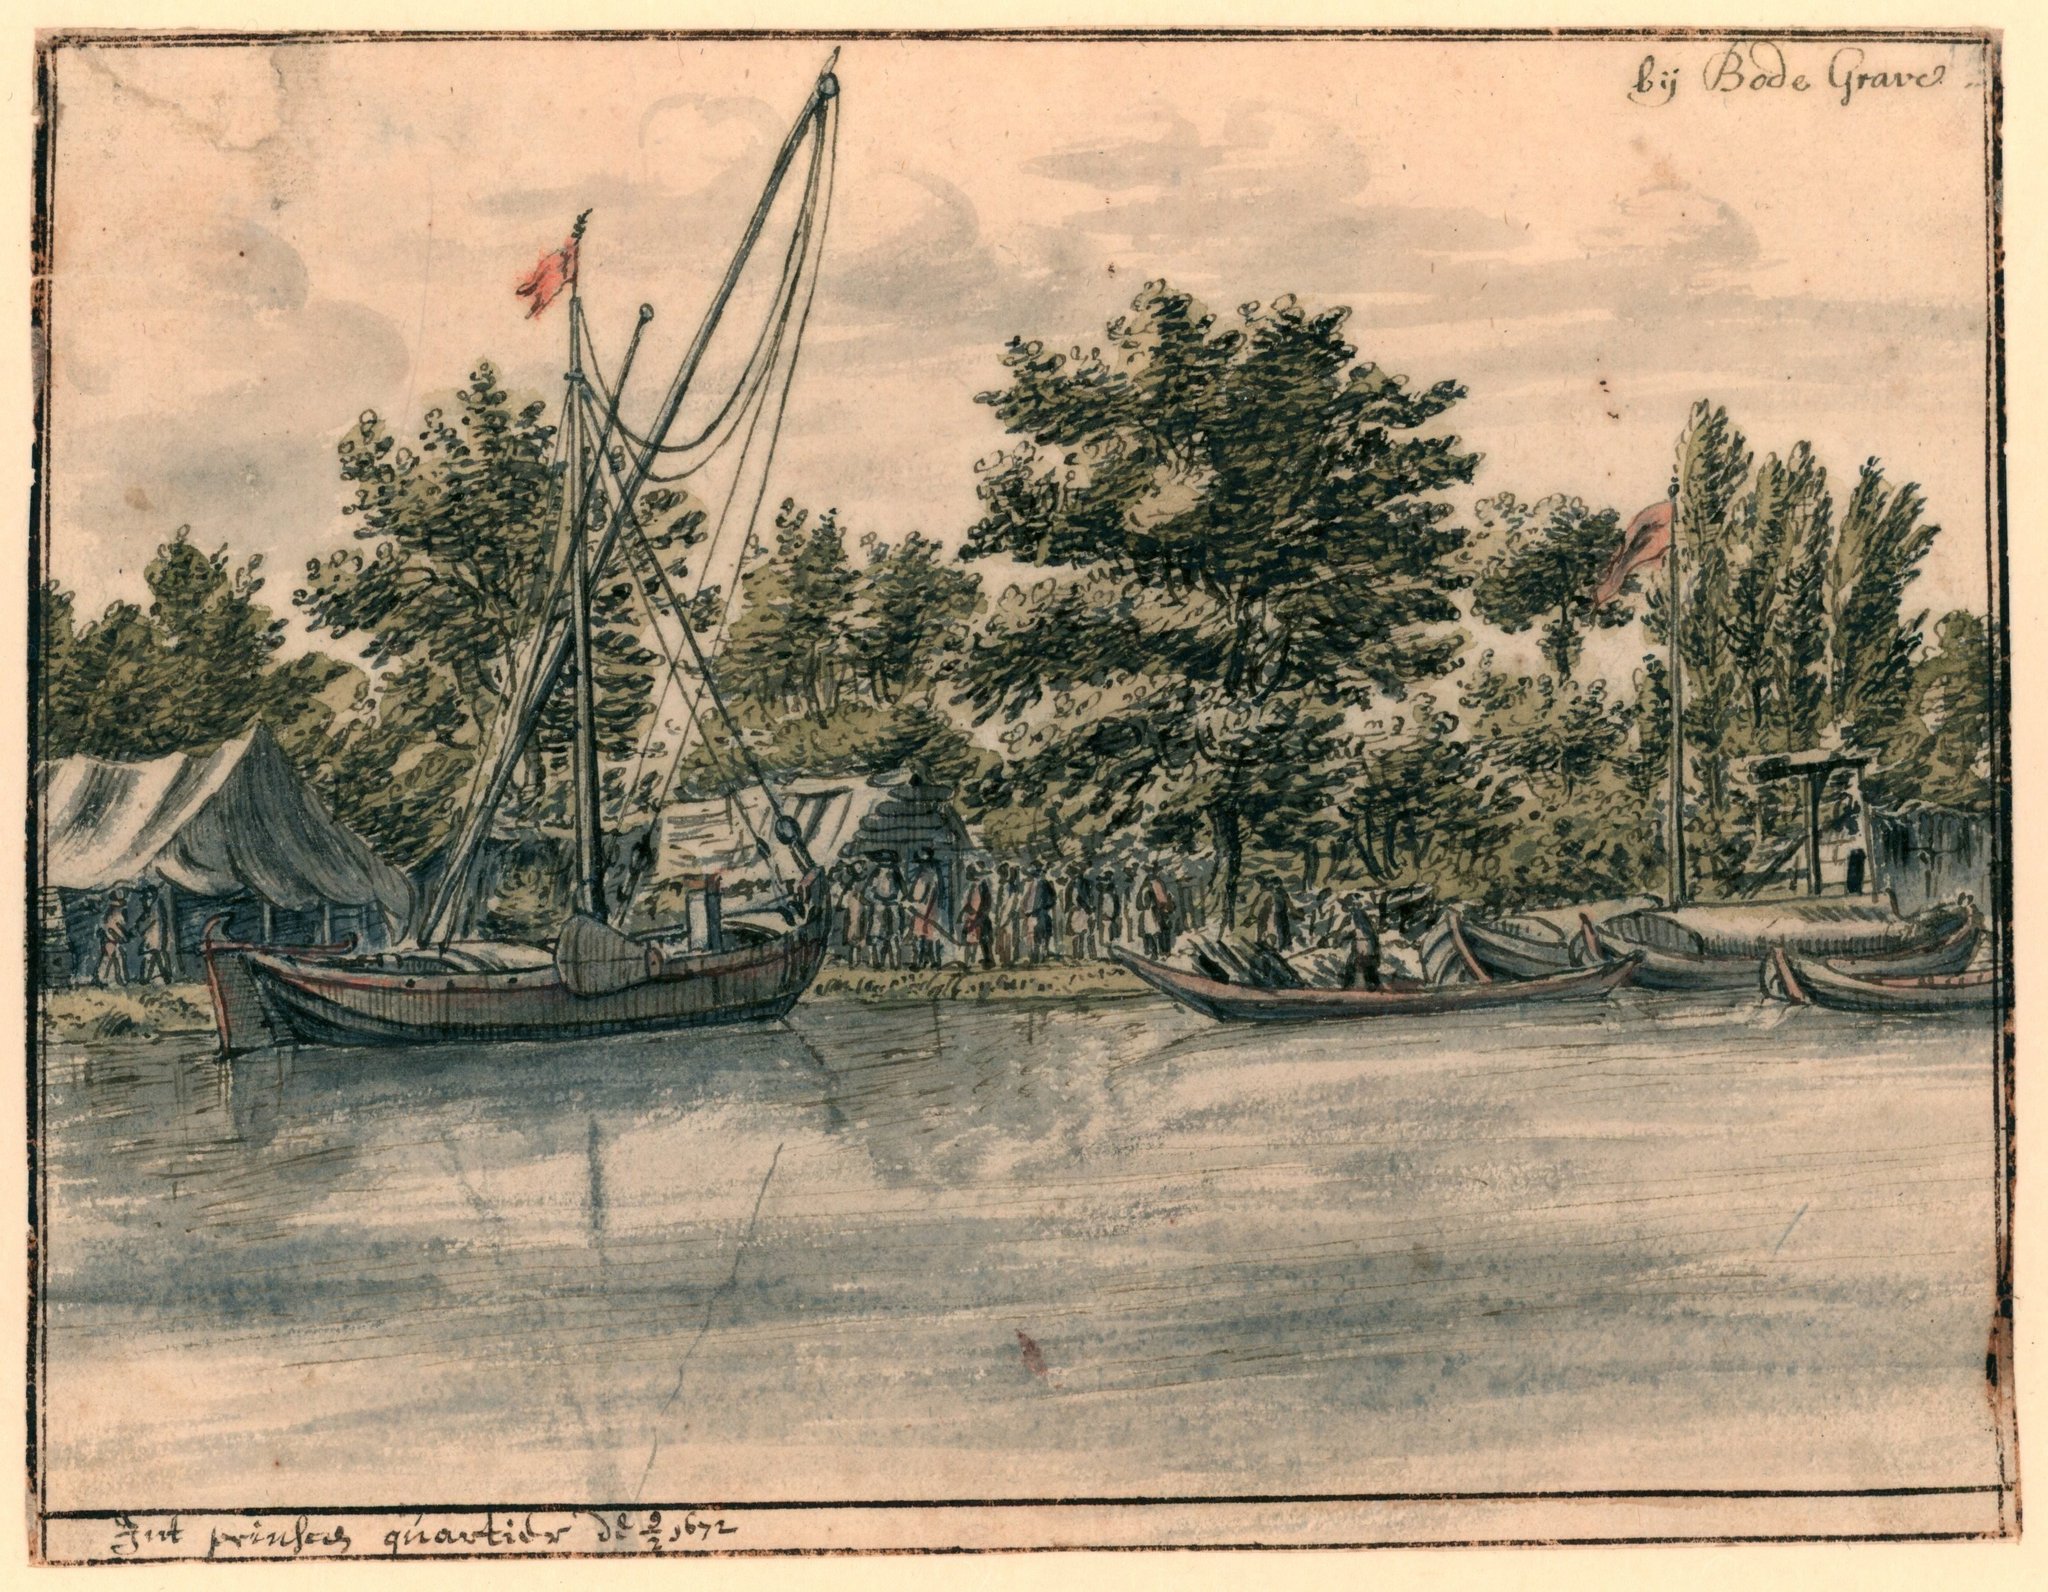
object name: drawing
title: View of Willem III’s Quarter near Bodegraven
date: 1672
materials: ink, paper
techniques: brush, pen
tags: the hague, william iii (prince of orange and king of england, scotland, and ireland), river, river bank, bodegraven, rampjaar (disaster year)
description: Gezicht op het kwartier van prins Willem en zijn troepen te Bodegraven aan de rivier de Oude Rijn op 2 september 1672. De tekening toont verschillende vaartuigen die aan de rivieroever liggen afgemeerd. Daarachter enige tenten van het kampement van prins Willem.